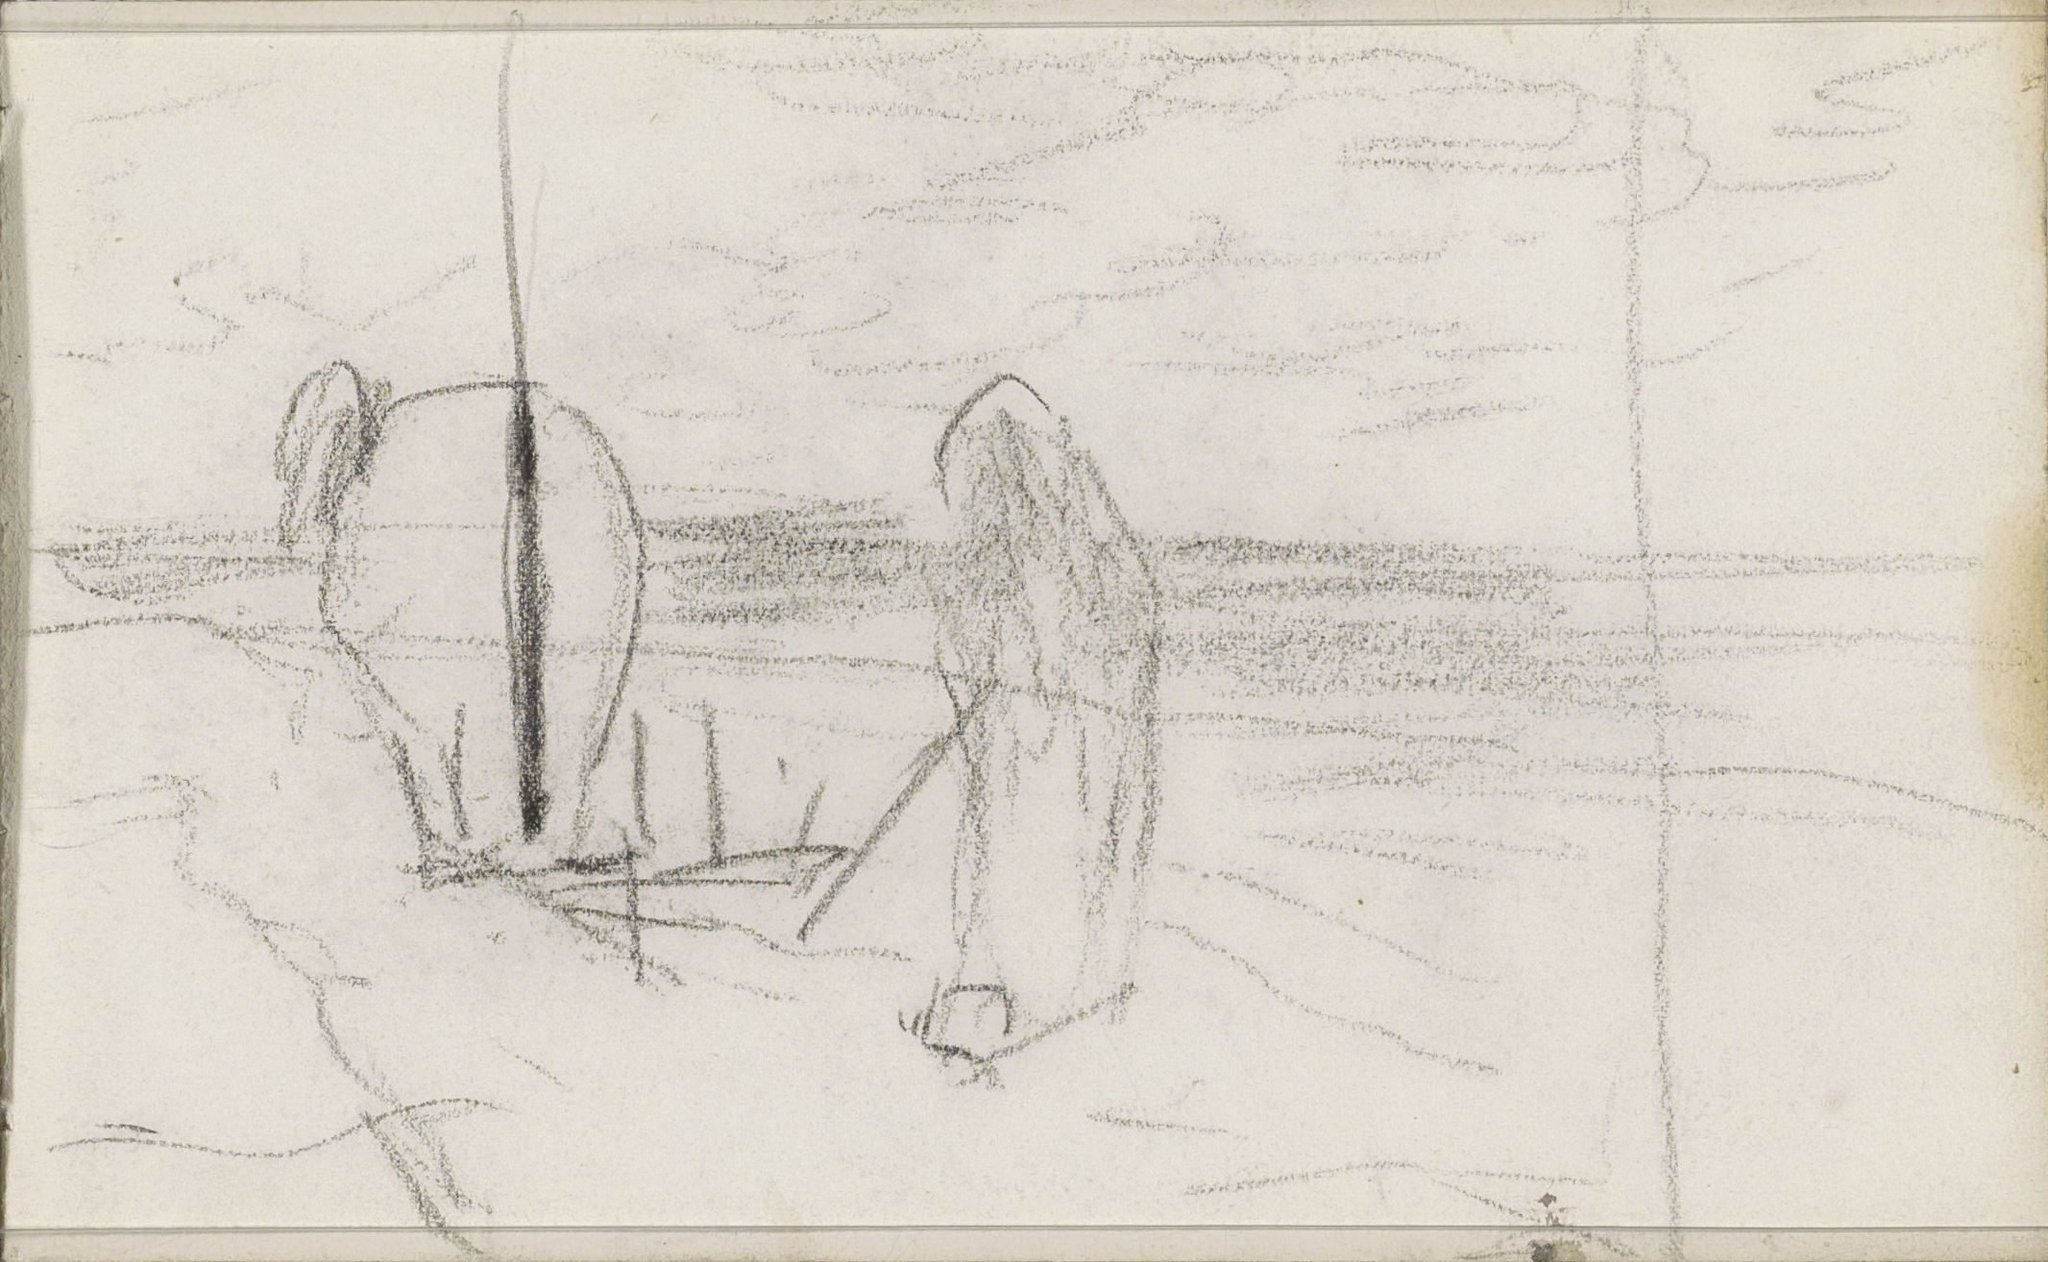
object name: sketchbook leaf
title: Ploegend dier op het land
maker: anton mauve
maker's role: draughtsman, painter, print maker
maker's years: 1838-1888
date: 1848-1888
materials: chalk, paper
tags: ploughing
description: Achter het dier, vermoedelijk een os, staat een figuur. Blad 38 recto uit een schetsboek met 43 bladen.